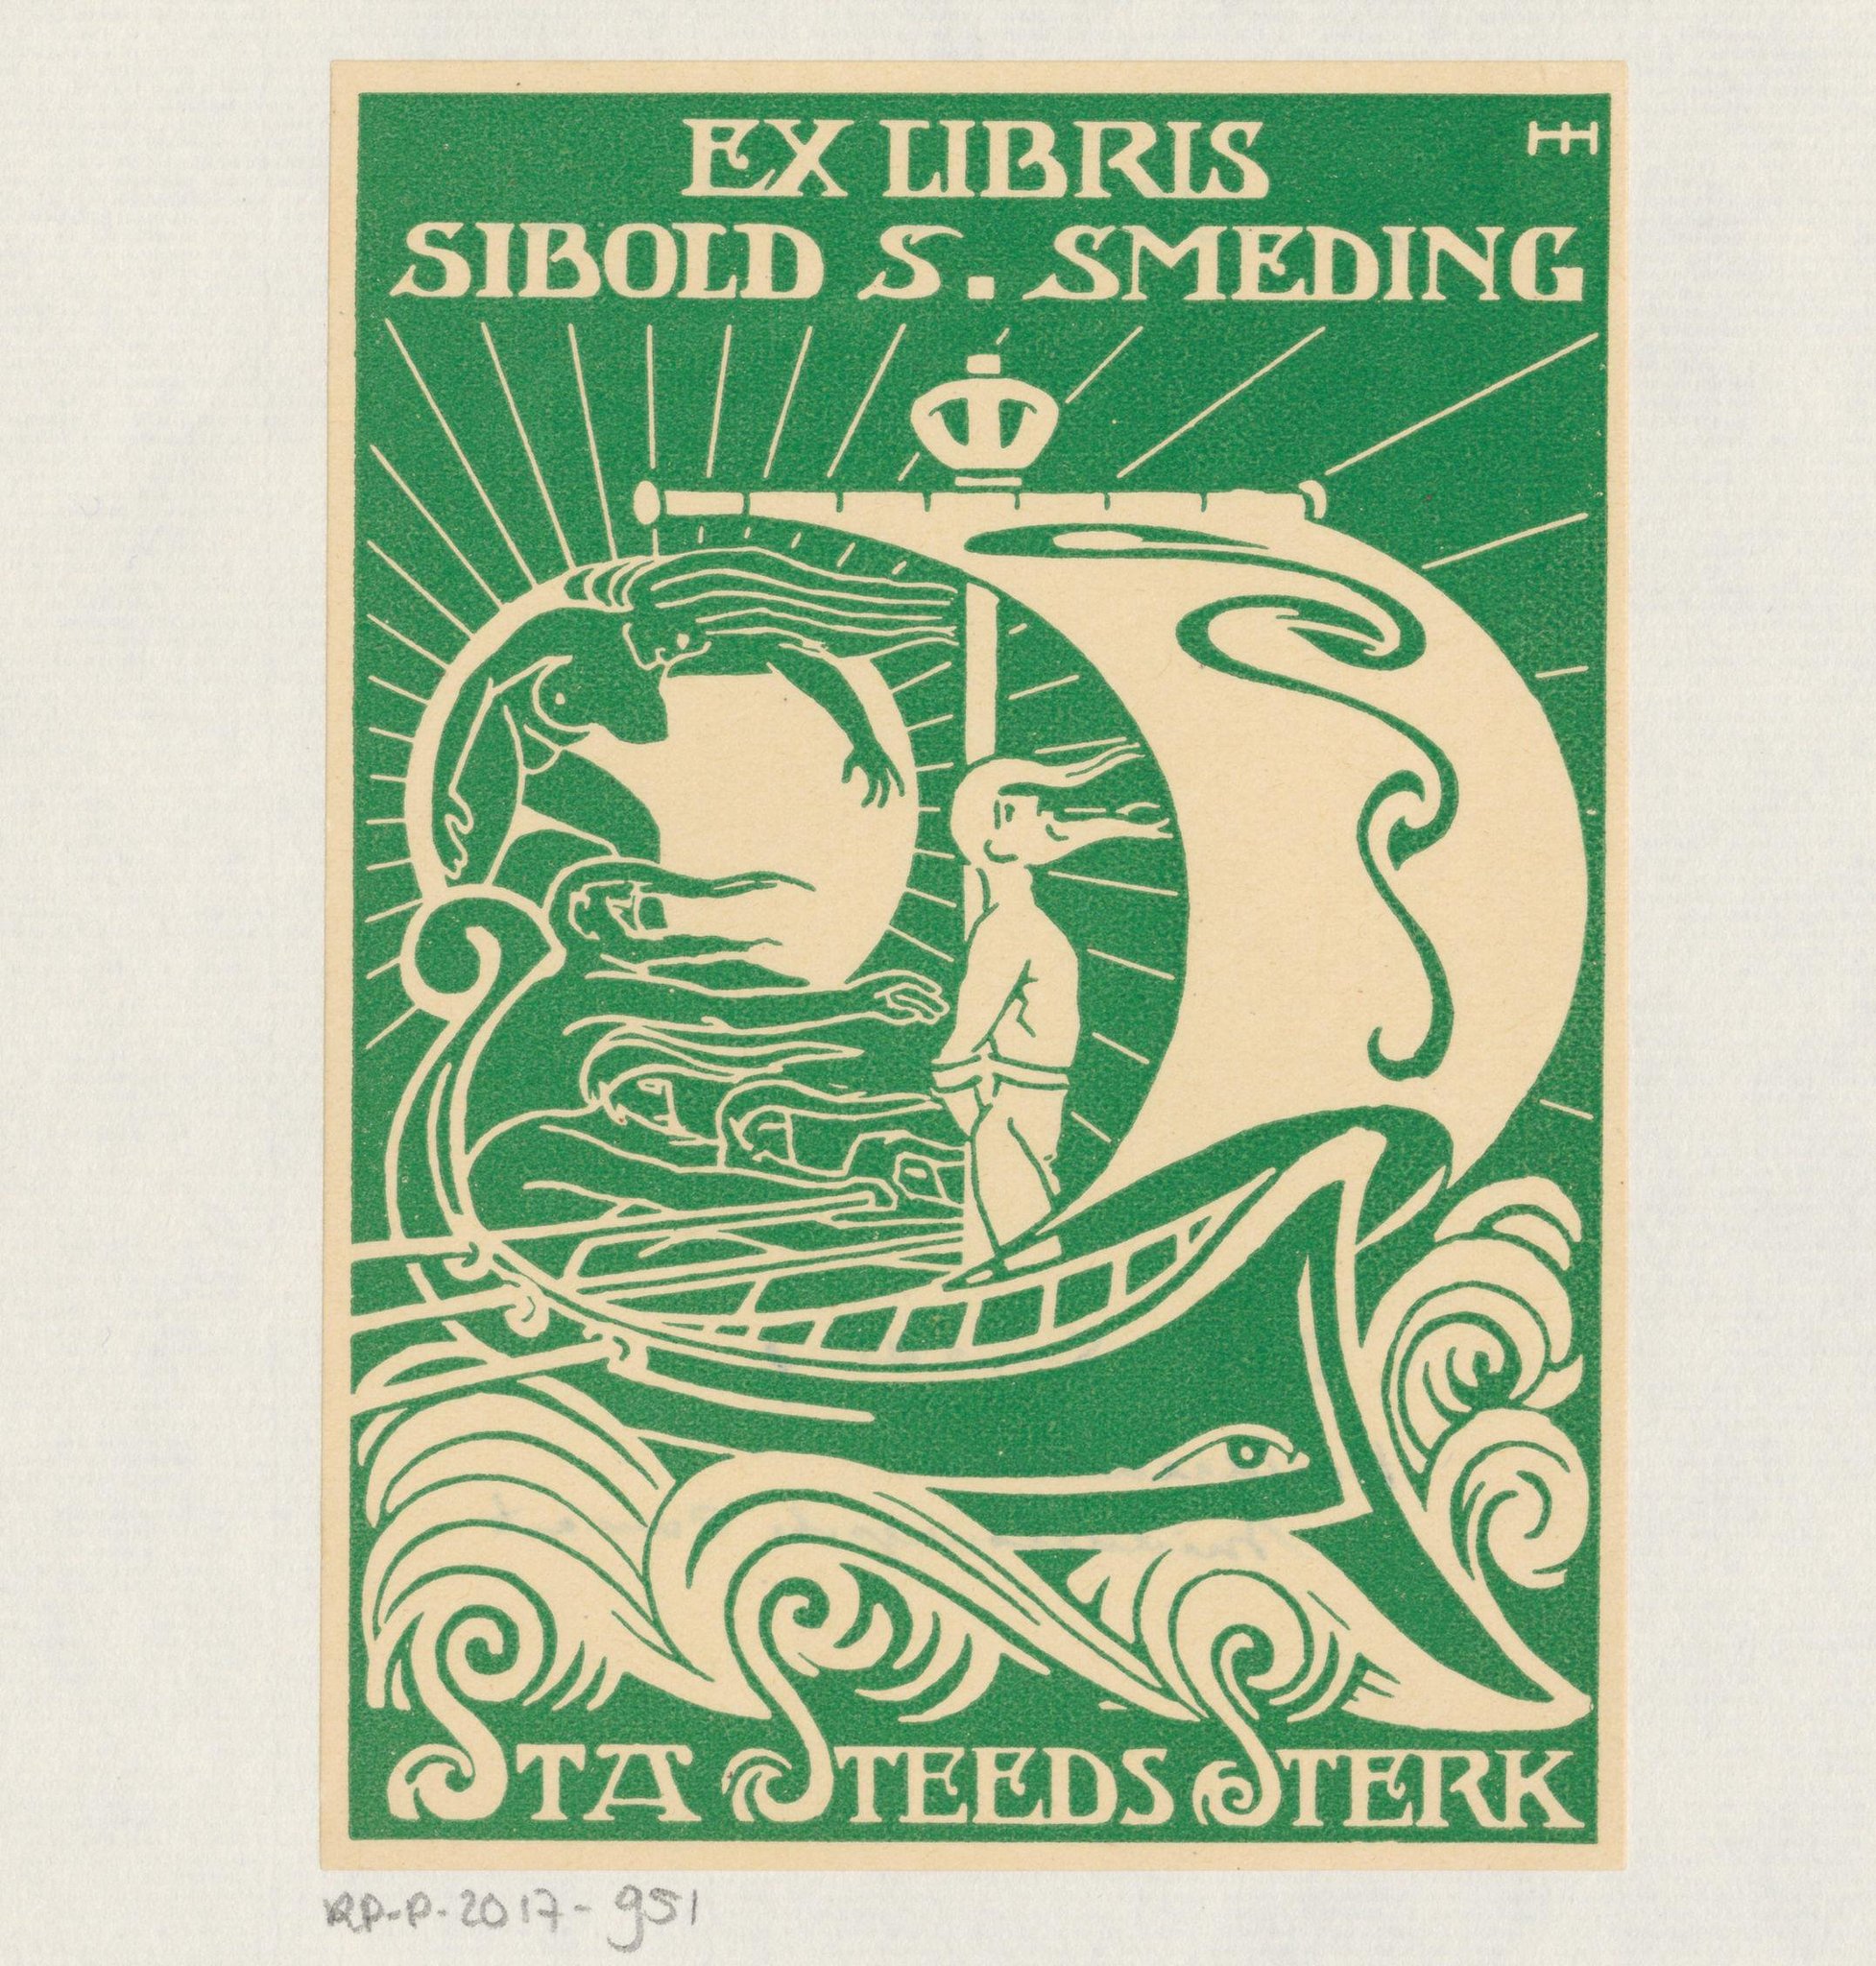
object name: bookplate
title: Ex libris van Sibold S. Smeding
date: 1906-1952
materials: paper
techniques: printing block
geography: netherlands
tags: ulysses, tied to the mast of his ship, passes the sirens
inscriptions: inscription: ‘S.S. Smeding / Hoofdredacteur / Middelburgsche Courant’